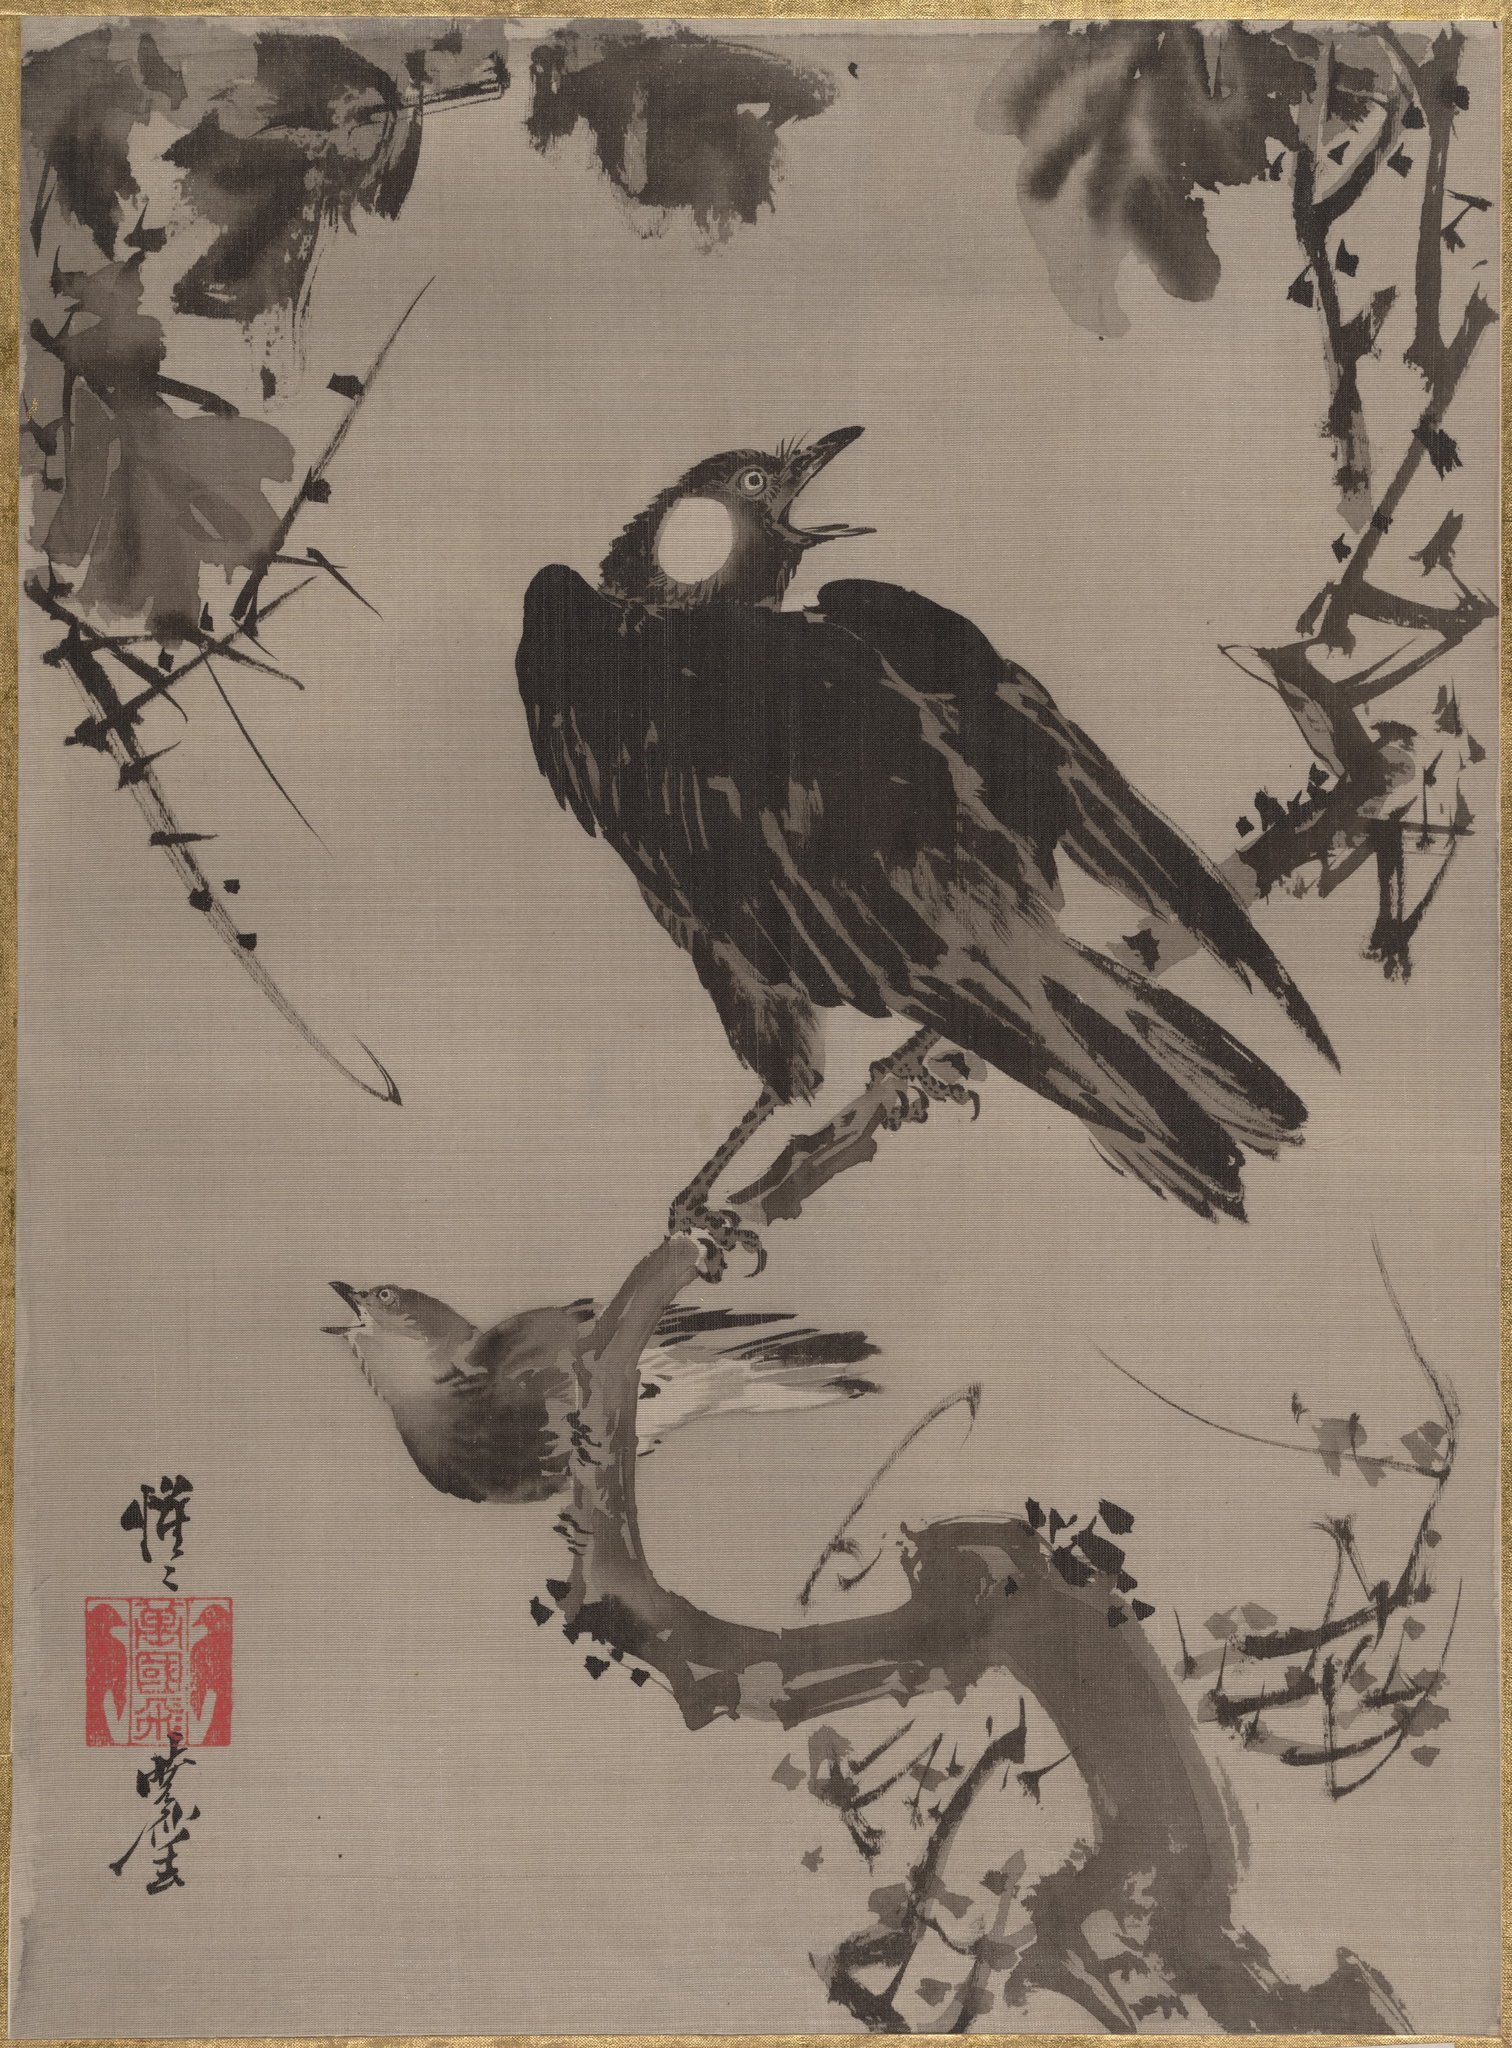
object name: album leaf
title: Starlings on a Branch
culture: japanese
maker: kawanabe kyōsai 河鍋暁斎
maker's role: artist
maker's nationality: japanese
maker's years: 1831-1889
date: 1887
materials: ink, silk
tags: birds